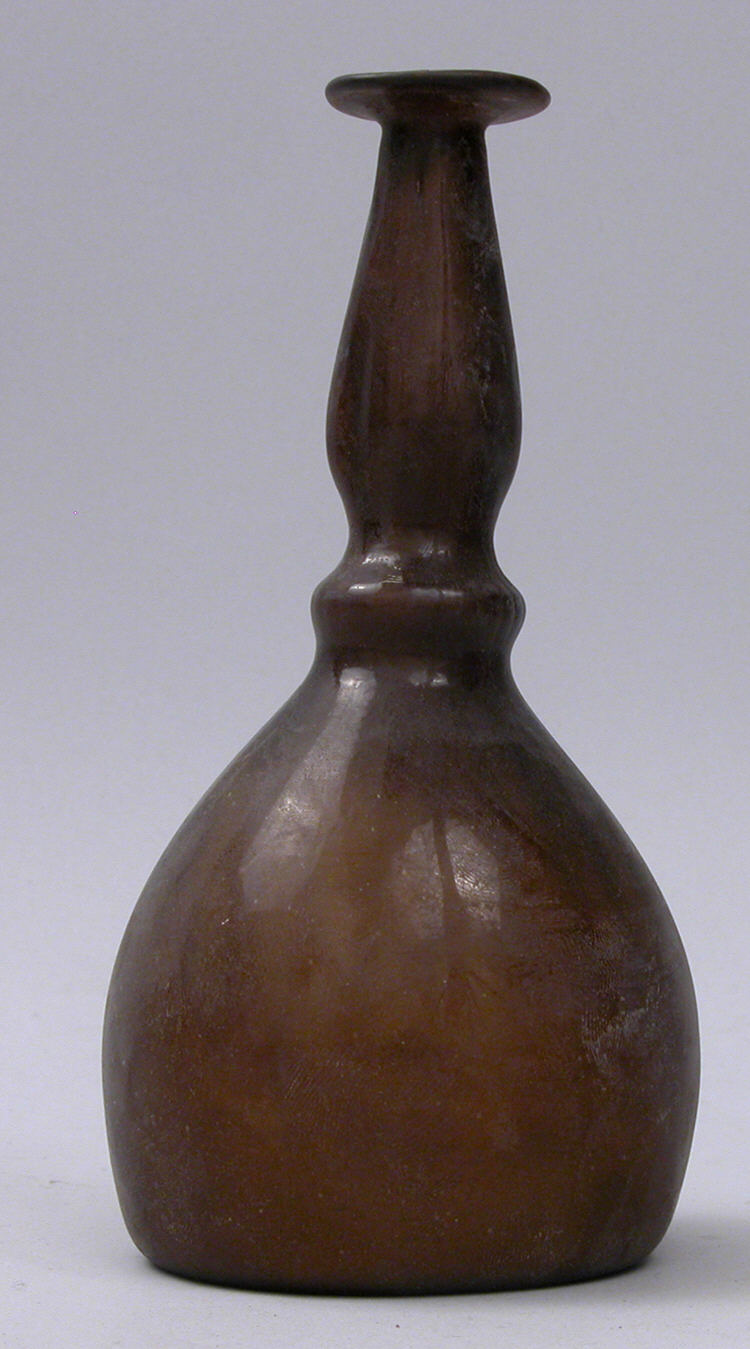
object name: bottle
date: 1701-1900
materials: glass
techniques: glassblowing, tooling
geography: iran